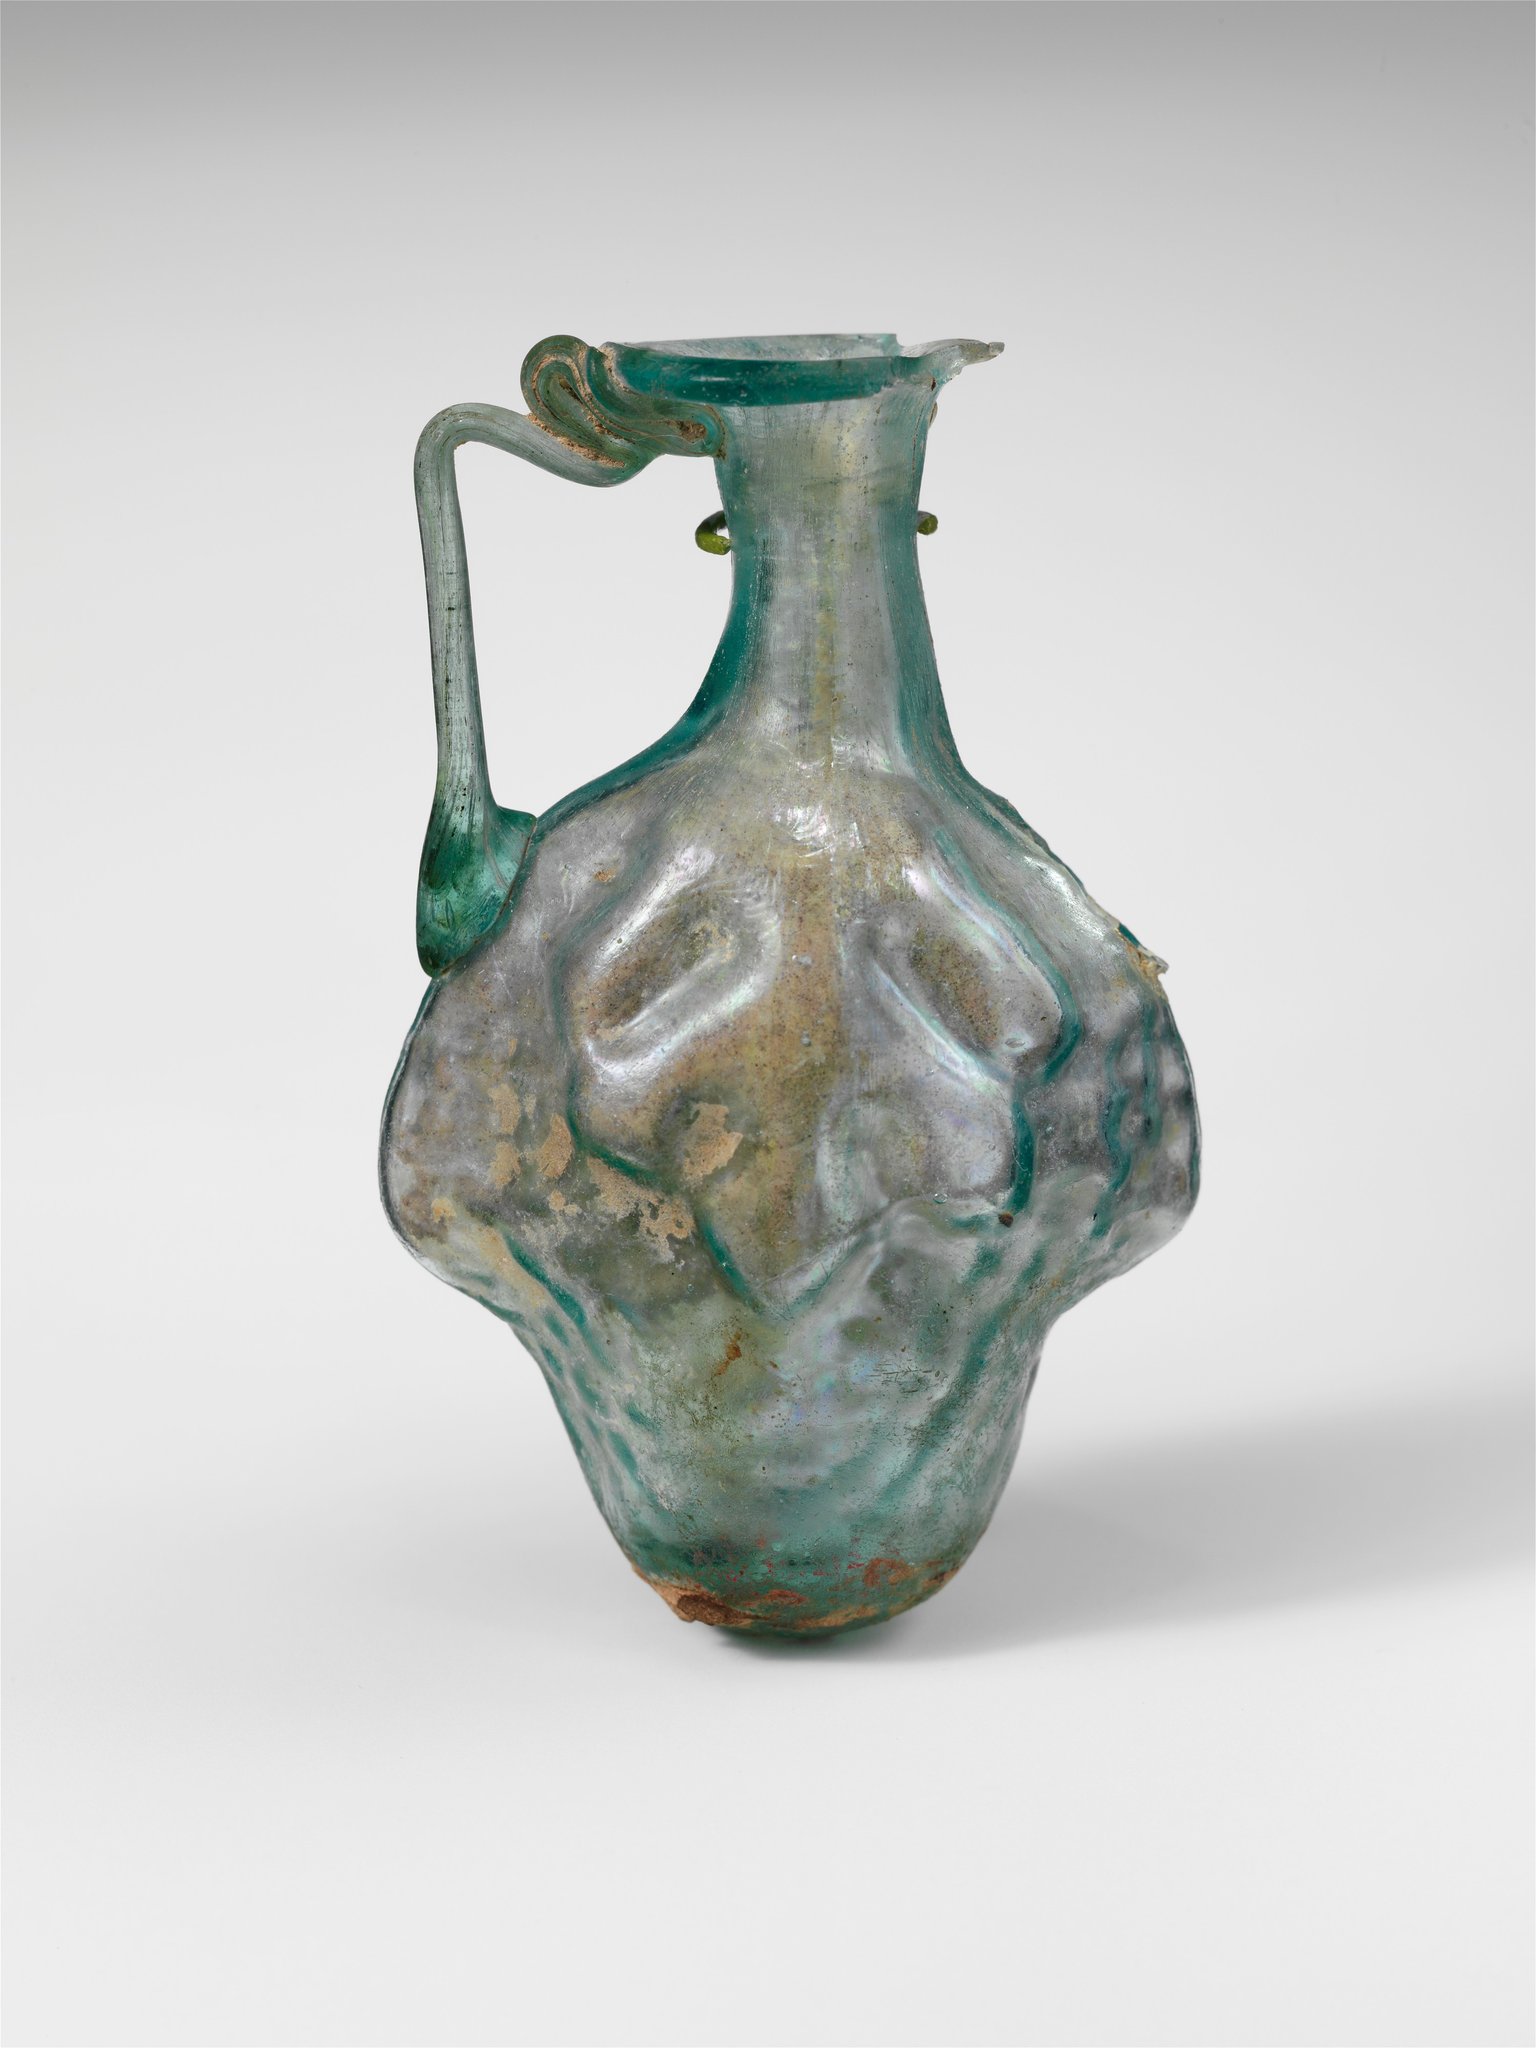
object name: bottle with stylized grape cluster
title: Glass bottle shaped like a bunch of grapes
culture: roman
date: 101-300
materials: glass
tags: grapes